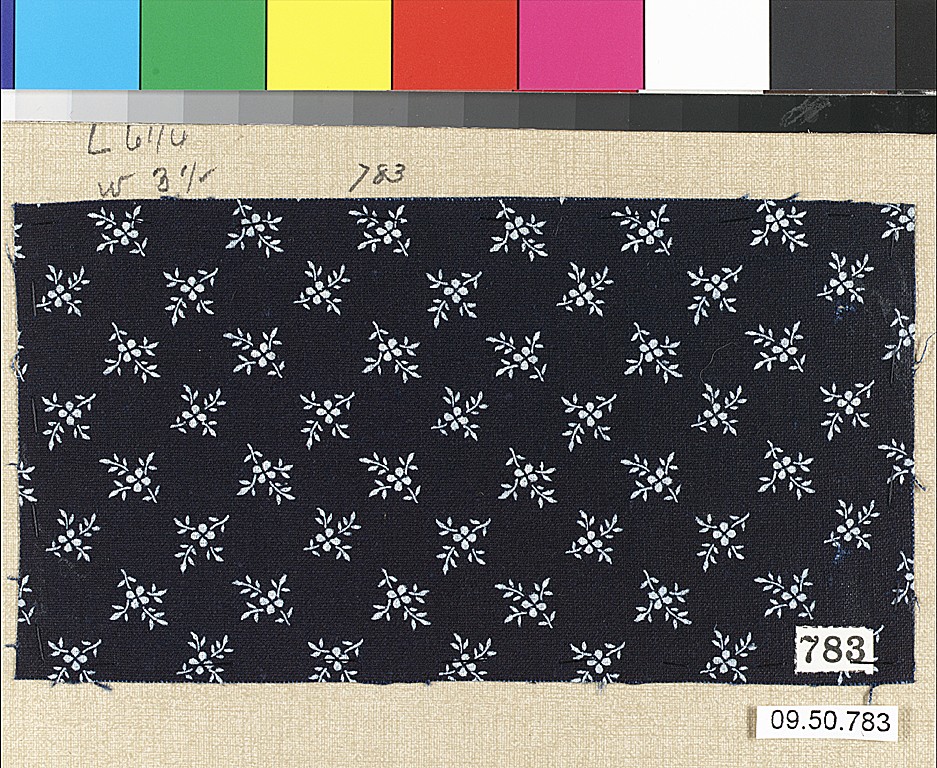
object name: piece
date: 1801-1900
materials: cotton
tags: flowers,leaves